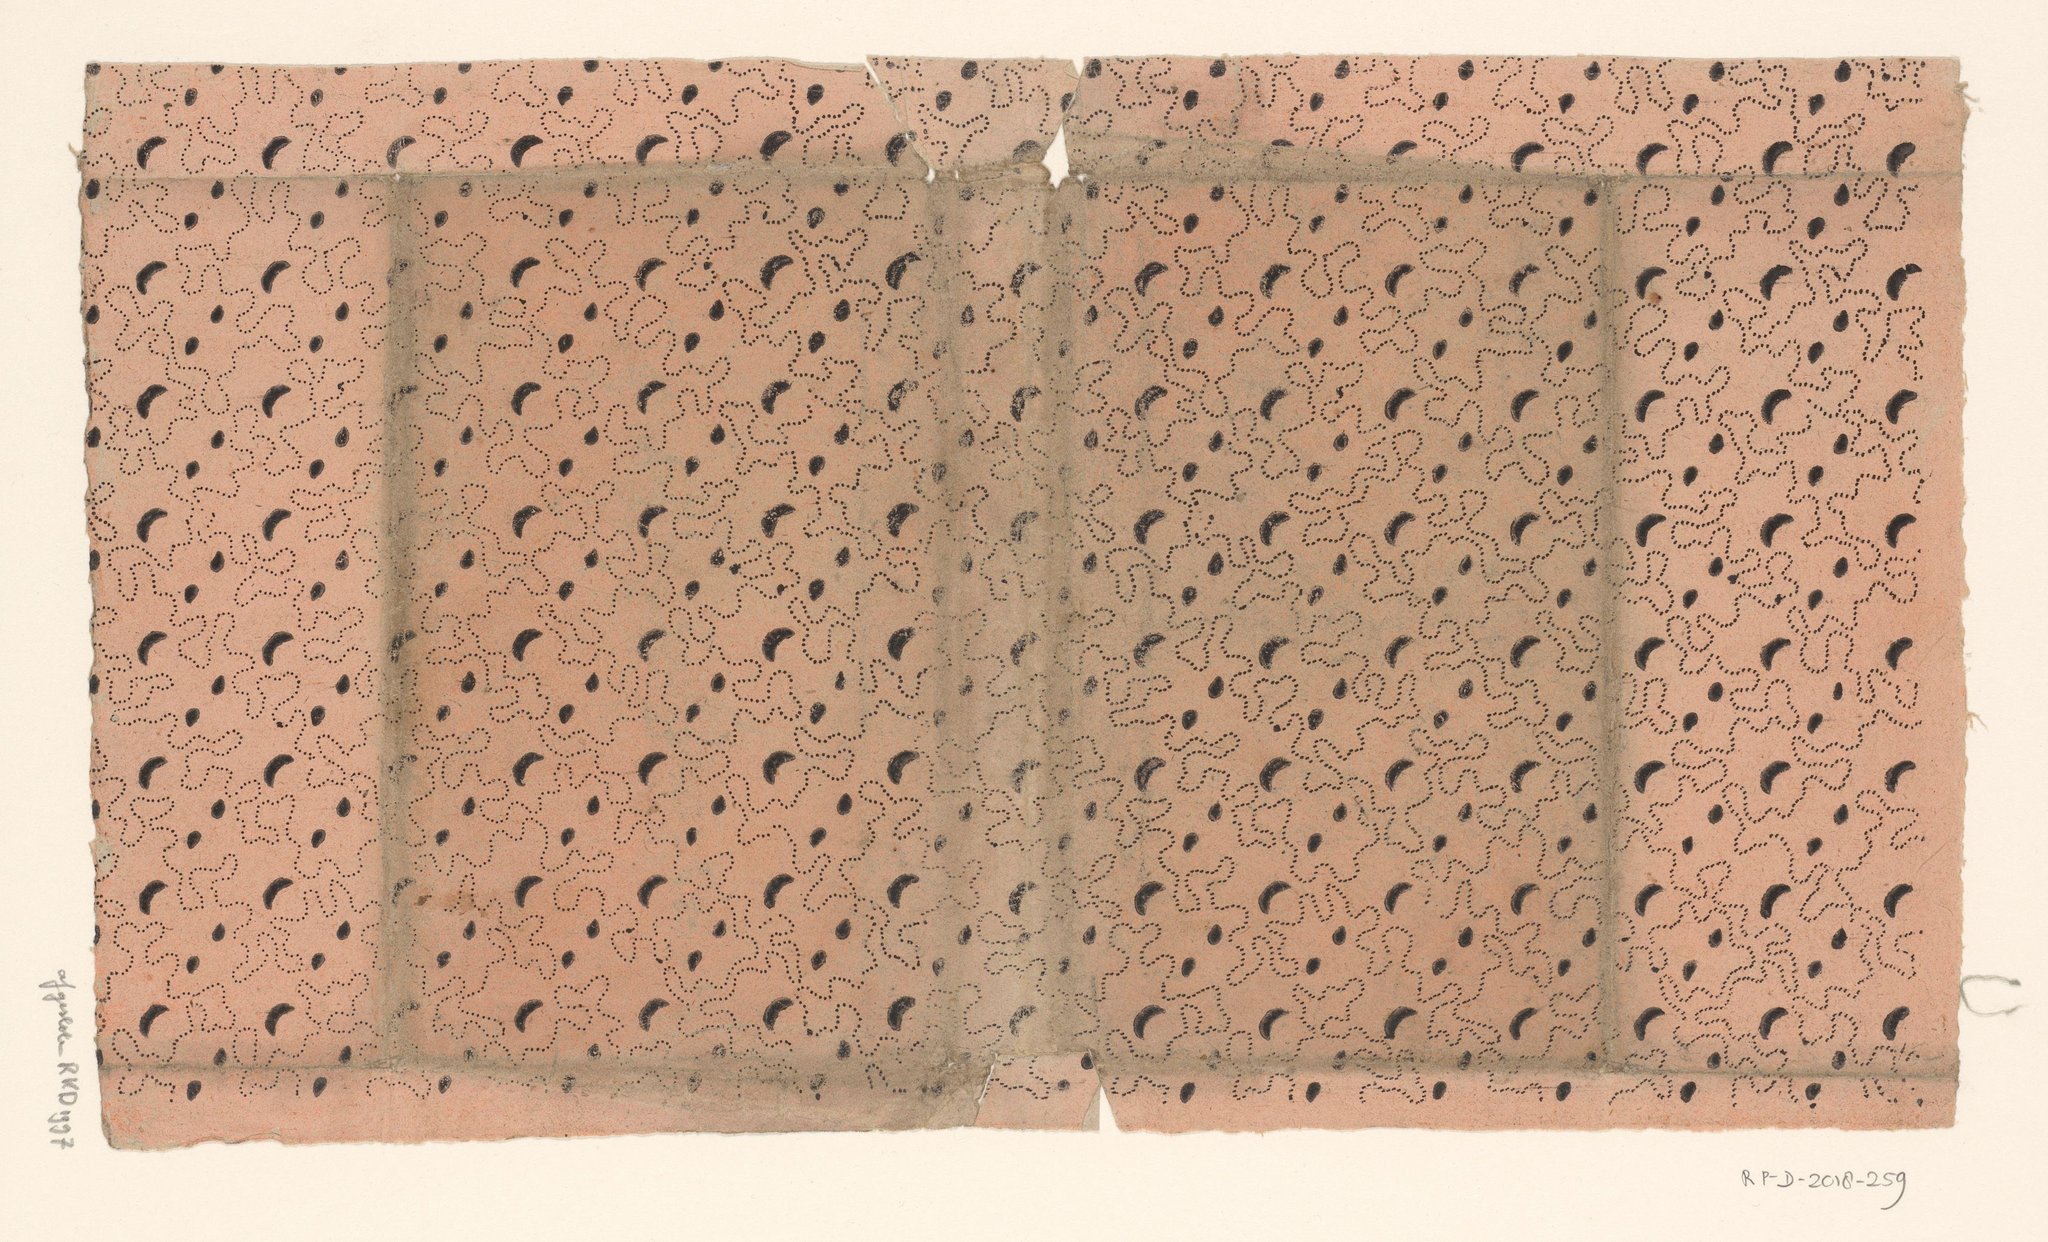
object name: printed paper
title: Blad met strooipatroon van maansikkel en stip tussen stippellijnen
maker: Anonymous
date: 1750-1900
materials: paper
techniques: printing block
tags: fantasy ornament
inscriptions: collector's mark: Lugt 2228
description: Blad met strooipatroon van maansikkel en stip tussen stippellijnen. Gebruikt als omslag, met insnijdingen bij de rug.